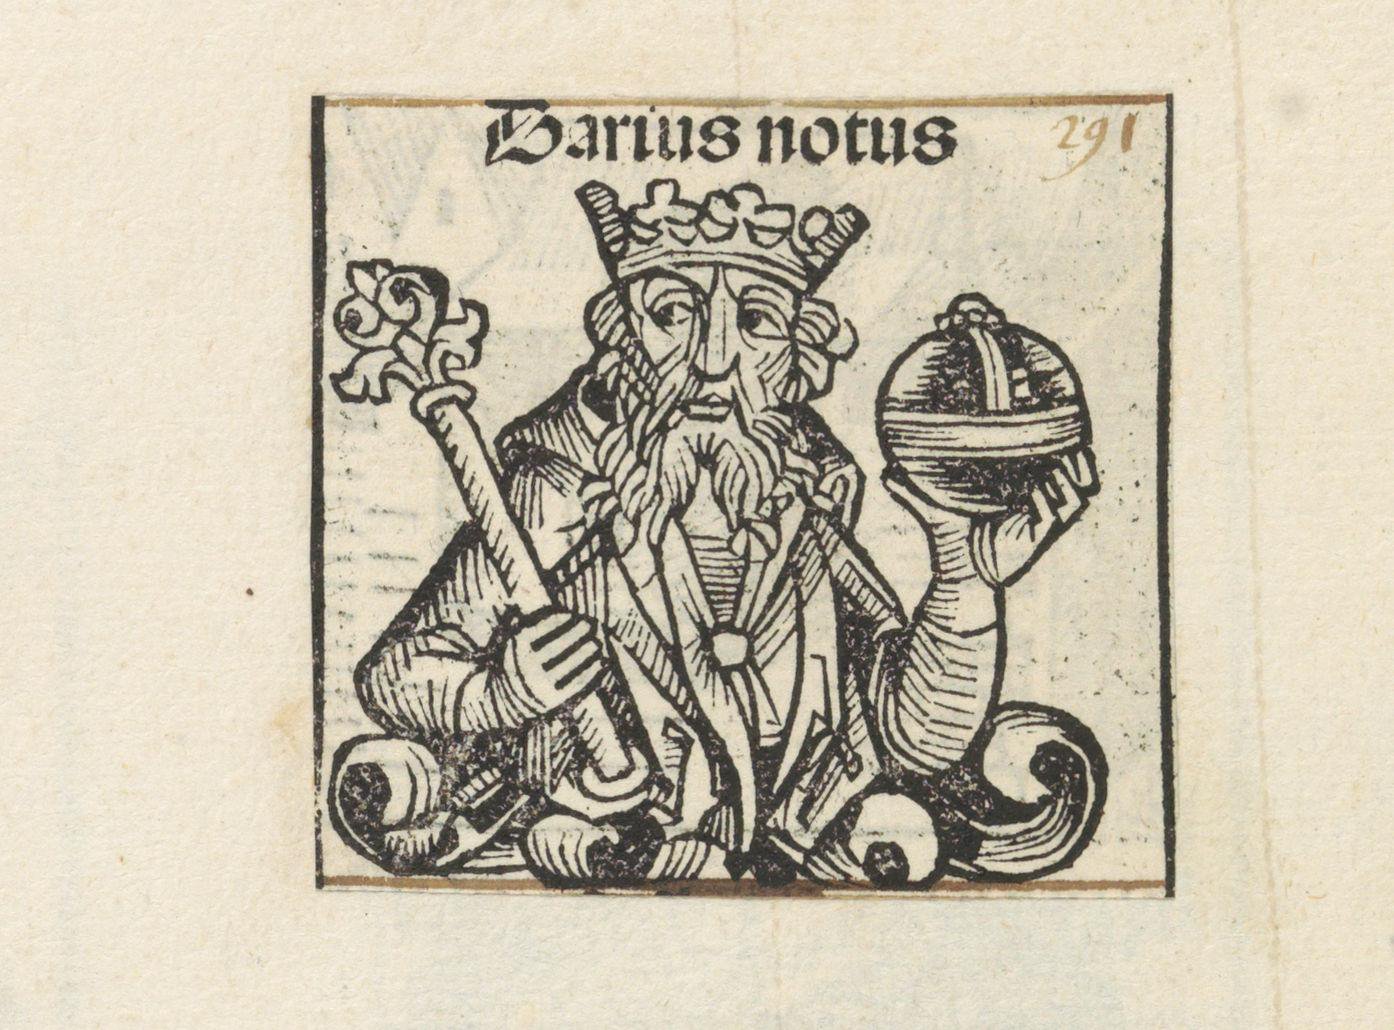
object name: album leaf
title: Liber Chronicarum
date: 1493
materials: paper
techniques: letterpress printing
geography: nuremberg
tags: king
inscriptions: inscription: ‘291’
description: Een bloemkelk met een koning. In zijn handen heeft hij een scepter en rijksappel. De voorstelling is onderdeel van de opeenvolging Perzische koningen in de Liber Chronicarum. De tekst identificeert de man als Darius II. De prent maakt deel uit van een album.